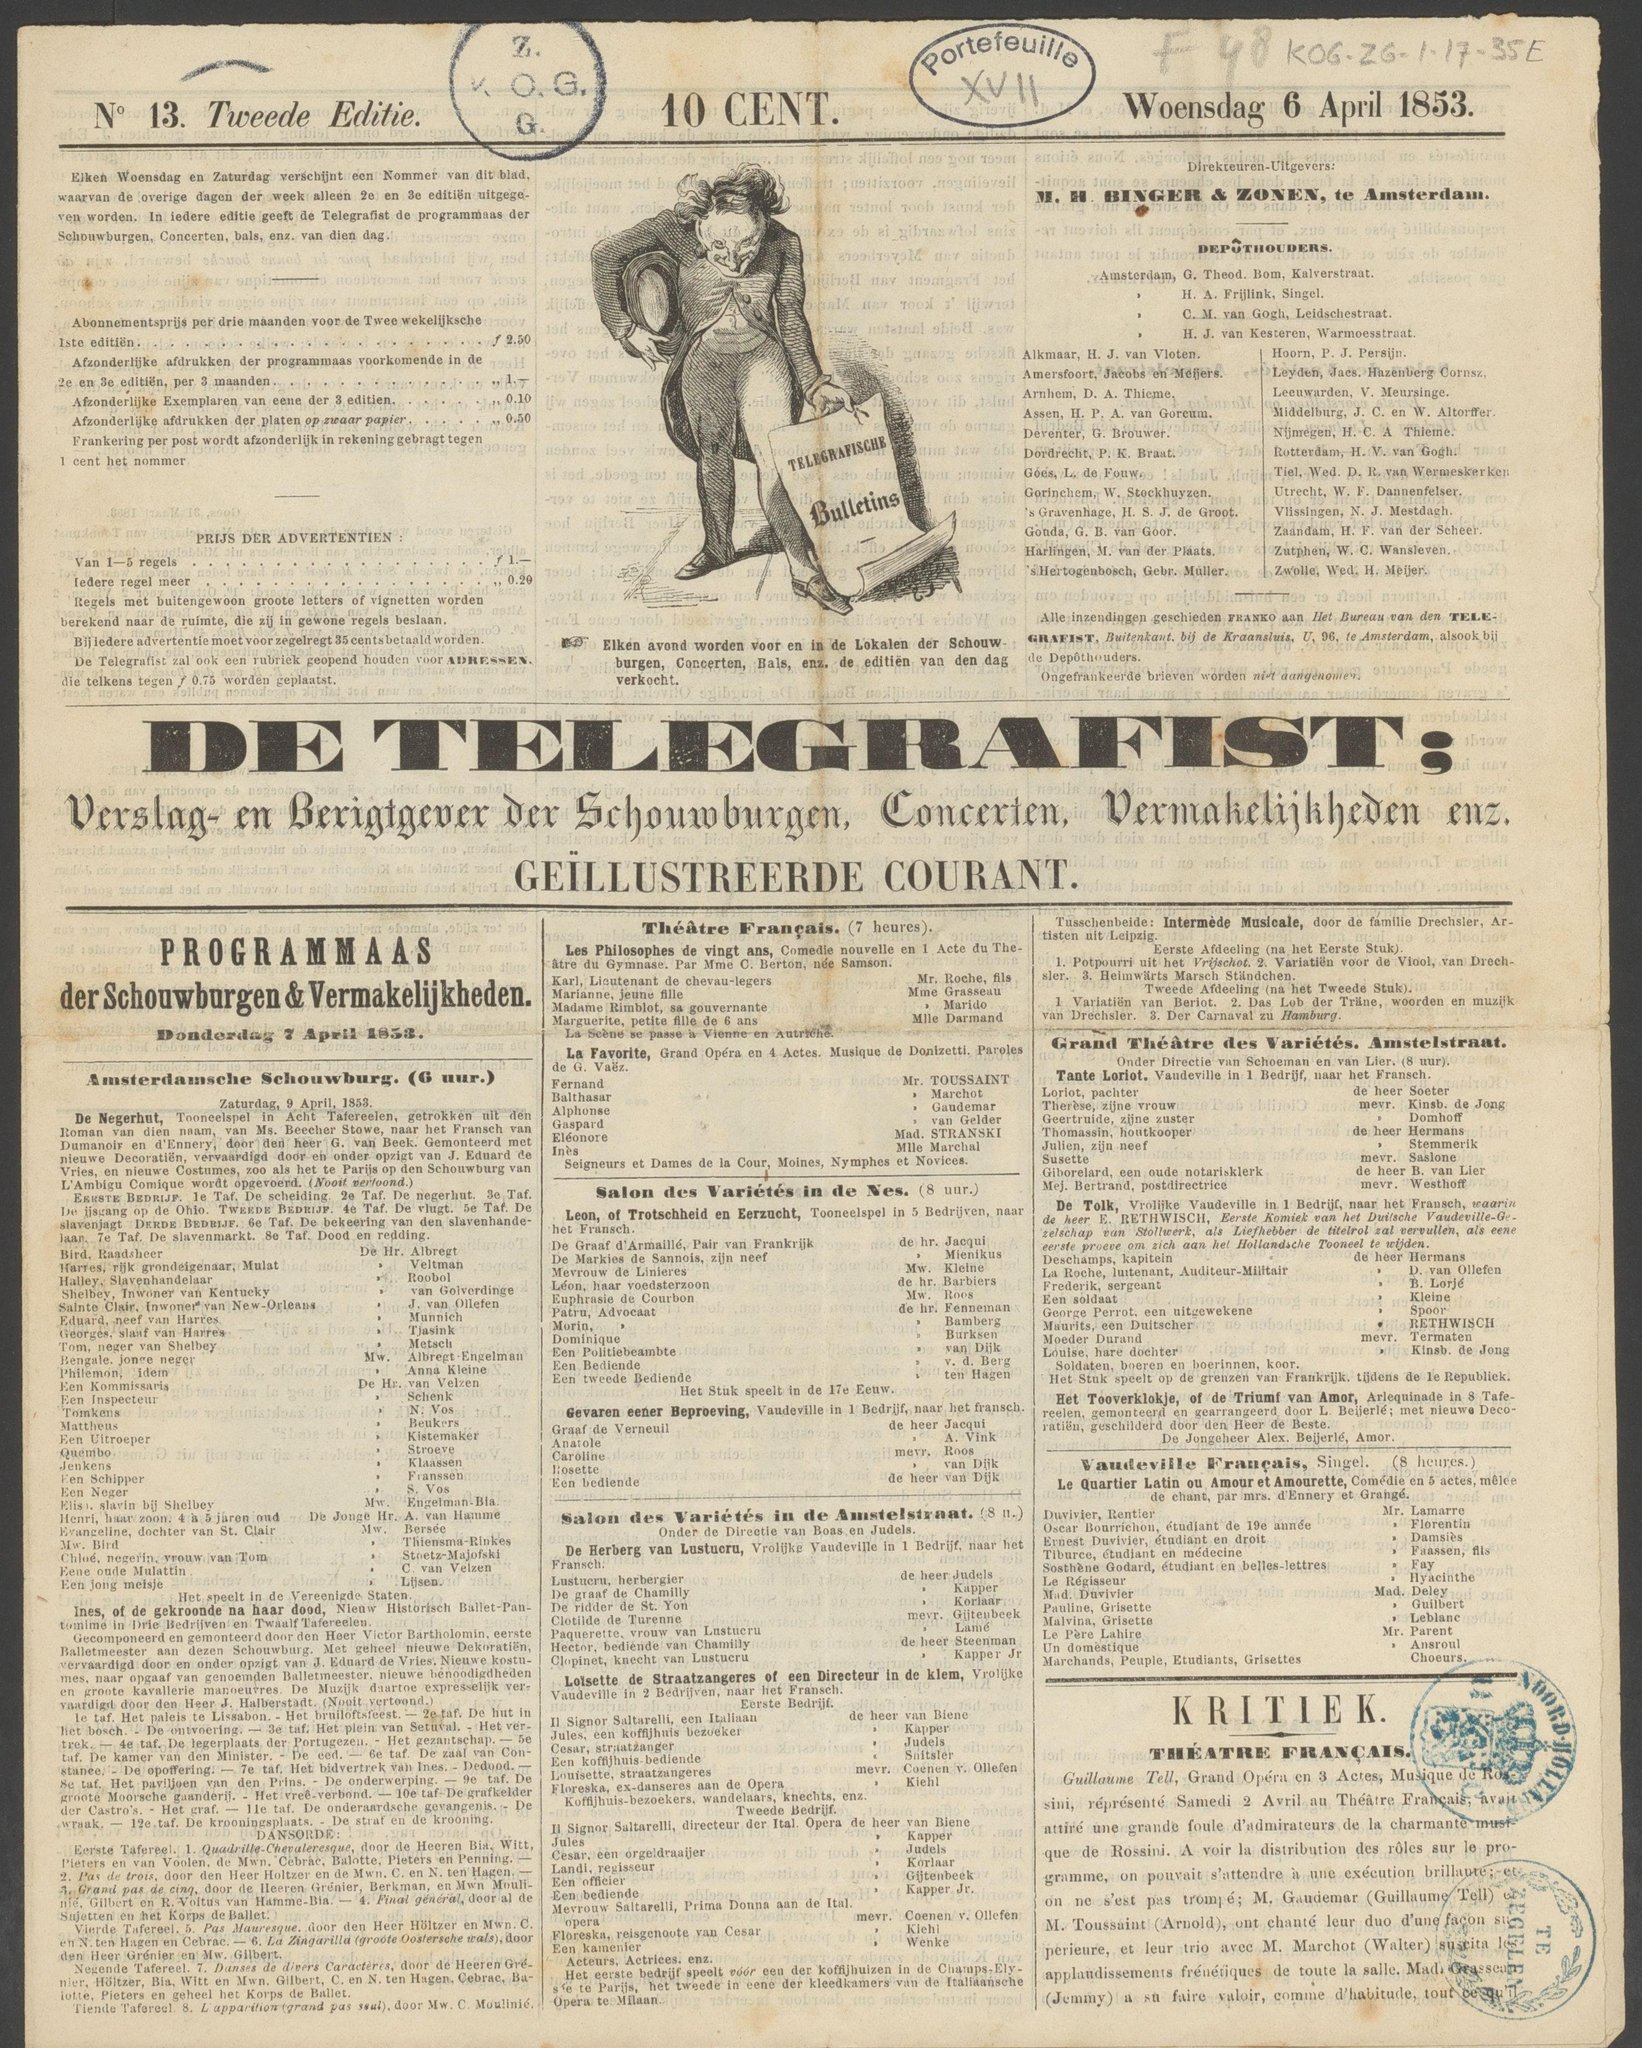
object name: print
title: De Telegrafist, krant voor schouwburgen, concerten en vermaak met een scène uit Don Alfred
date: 1853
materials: paper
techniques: letterpress printing, lithograph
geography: amsterdam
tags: slave-trade, military service, theatre, theatrical performance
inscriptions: stamp, collector's mark: Lugt 1641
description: De Telegrafist, krant voor schouwburgen, concerten en vermaak. Linksboven genummerd: No 13. Tweede Editie. Met een scène uit Don Alfred. Onderwerpsrubrieken binnen de Atlas Zeden en Gewoonten: Tooneel, Toneelprogramma’s.